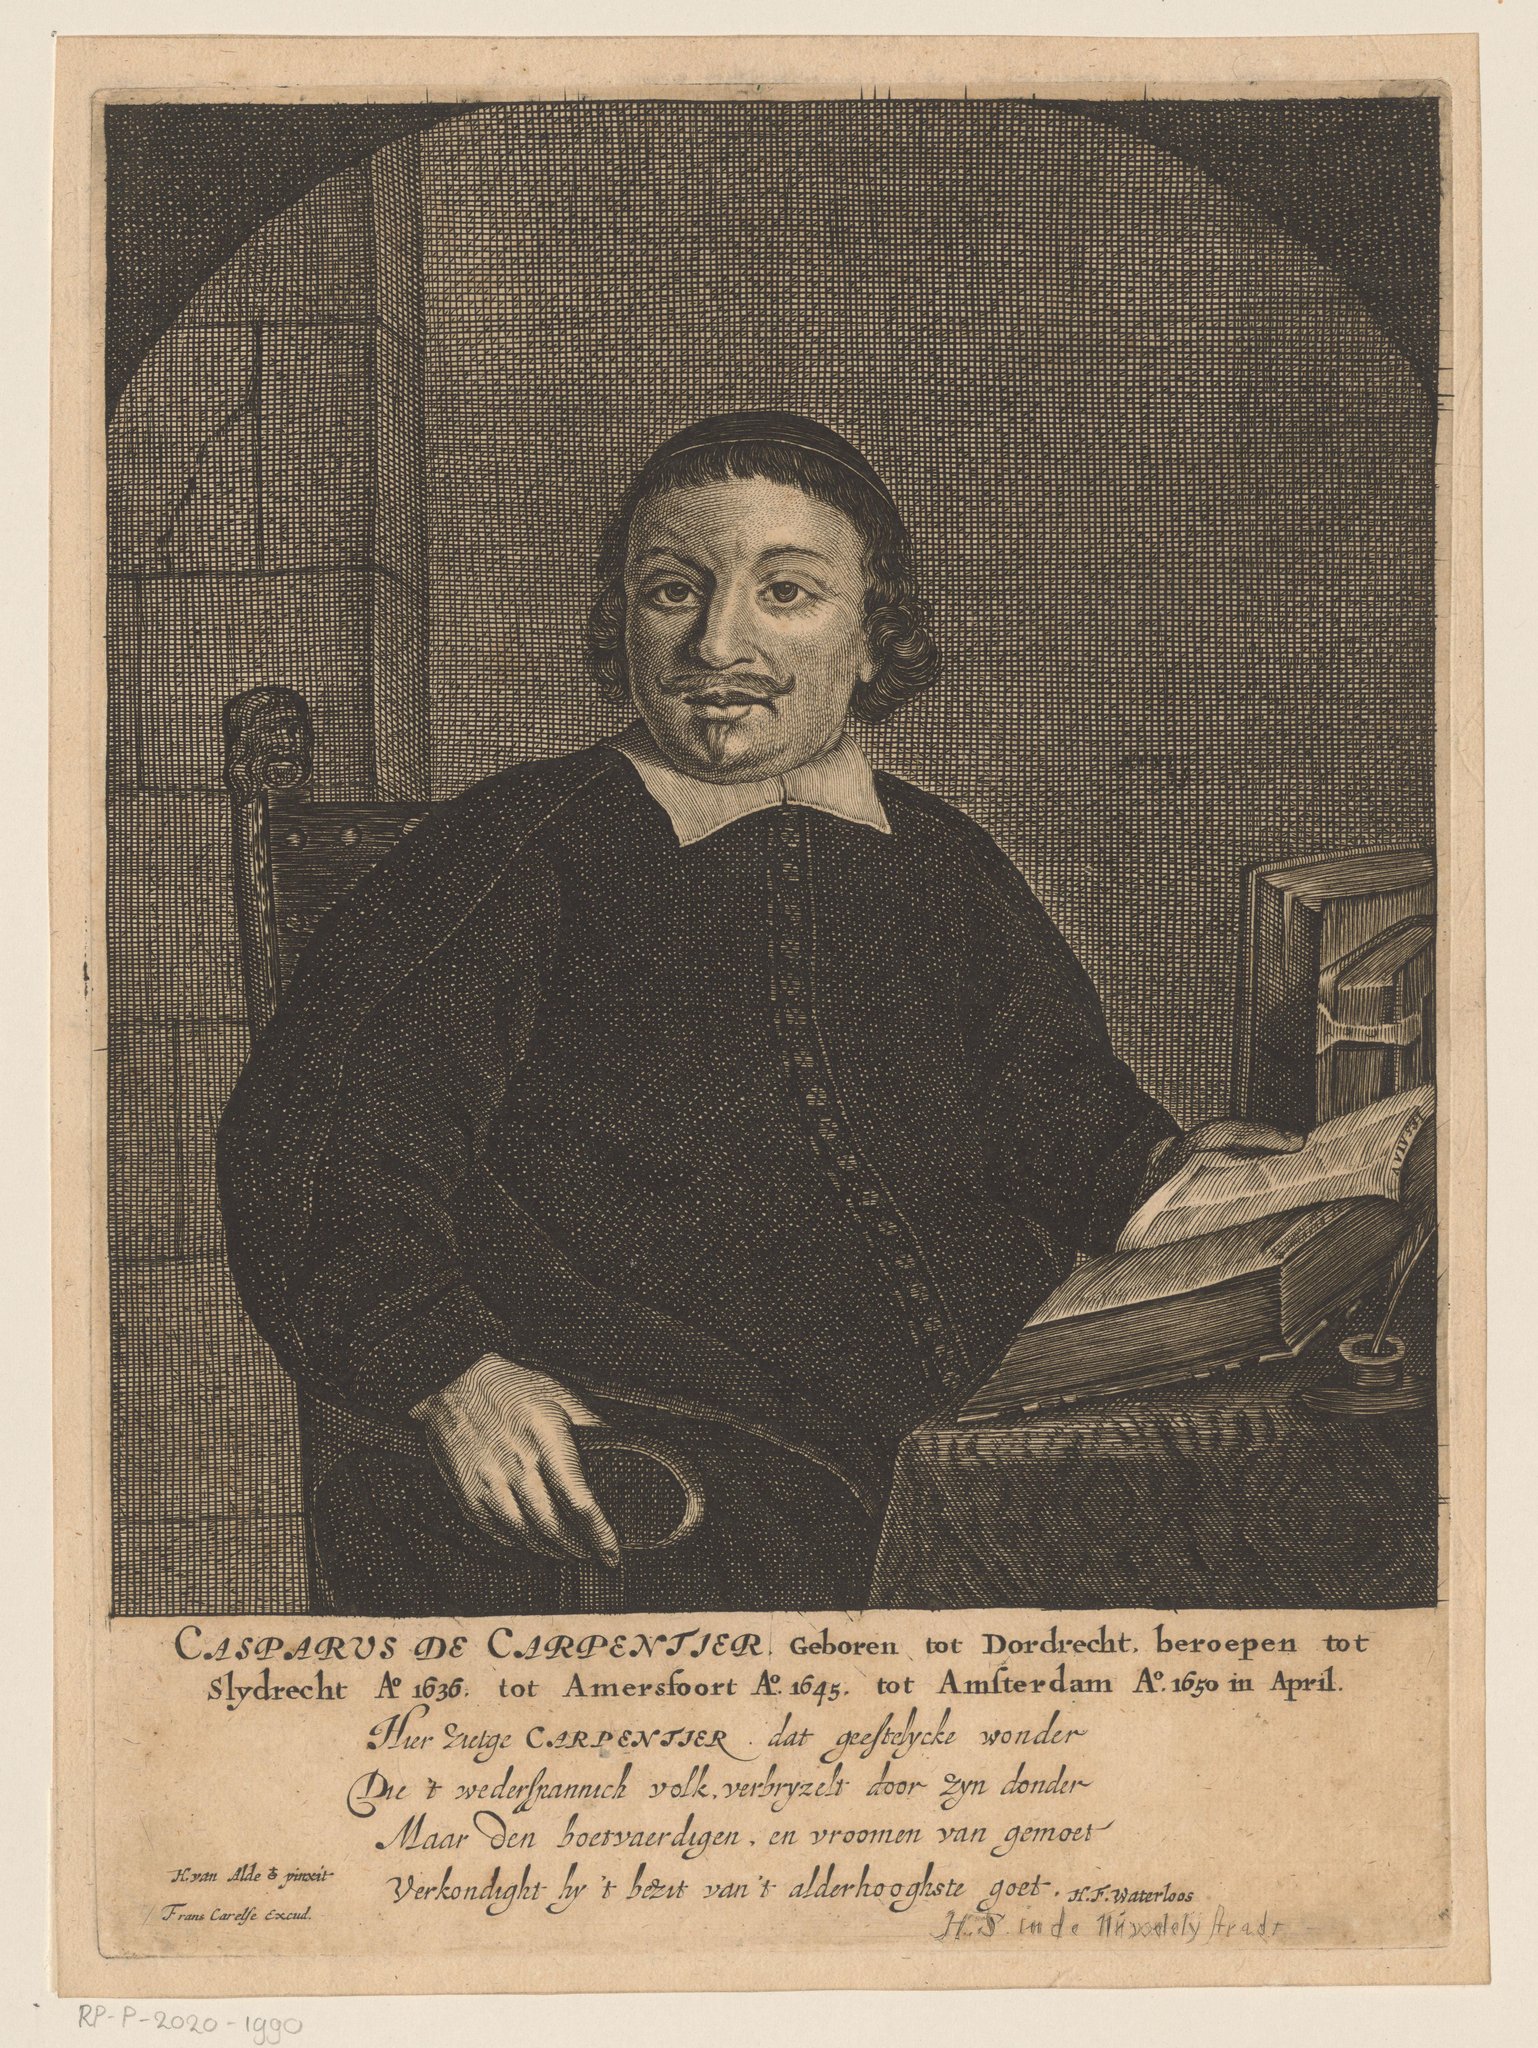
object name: print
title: Portret van Caspar de Carpentier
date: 1665-1681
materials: paper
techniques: engraving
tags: caspar de carpentier, historical persons